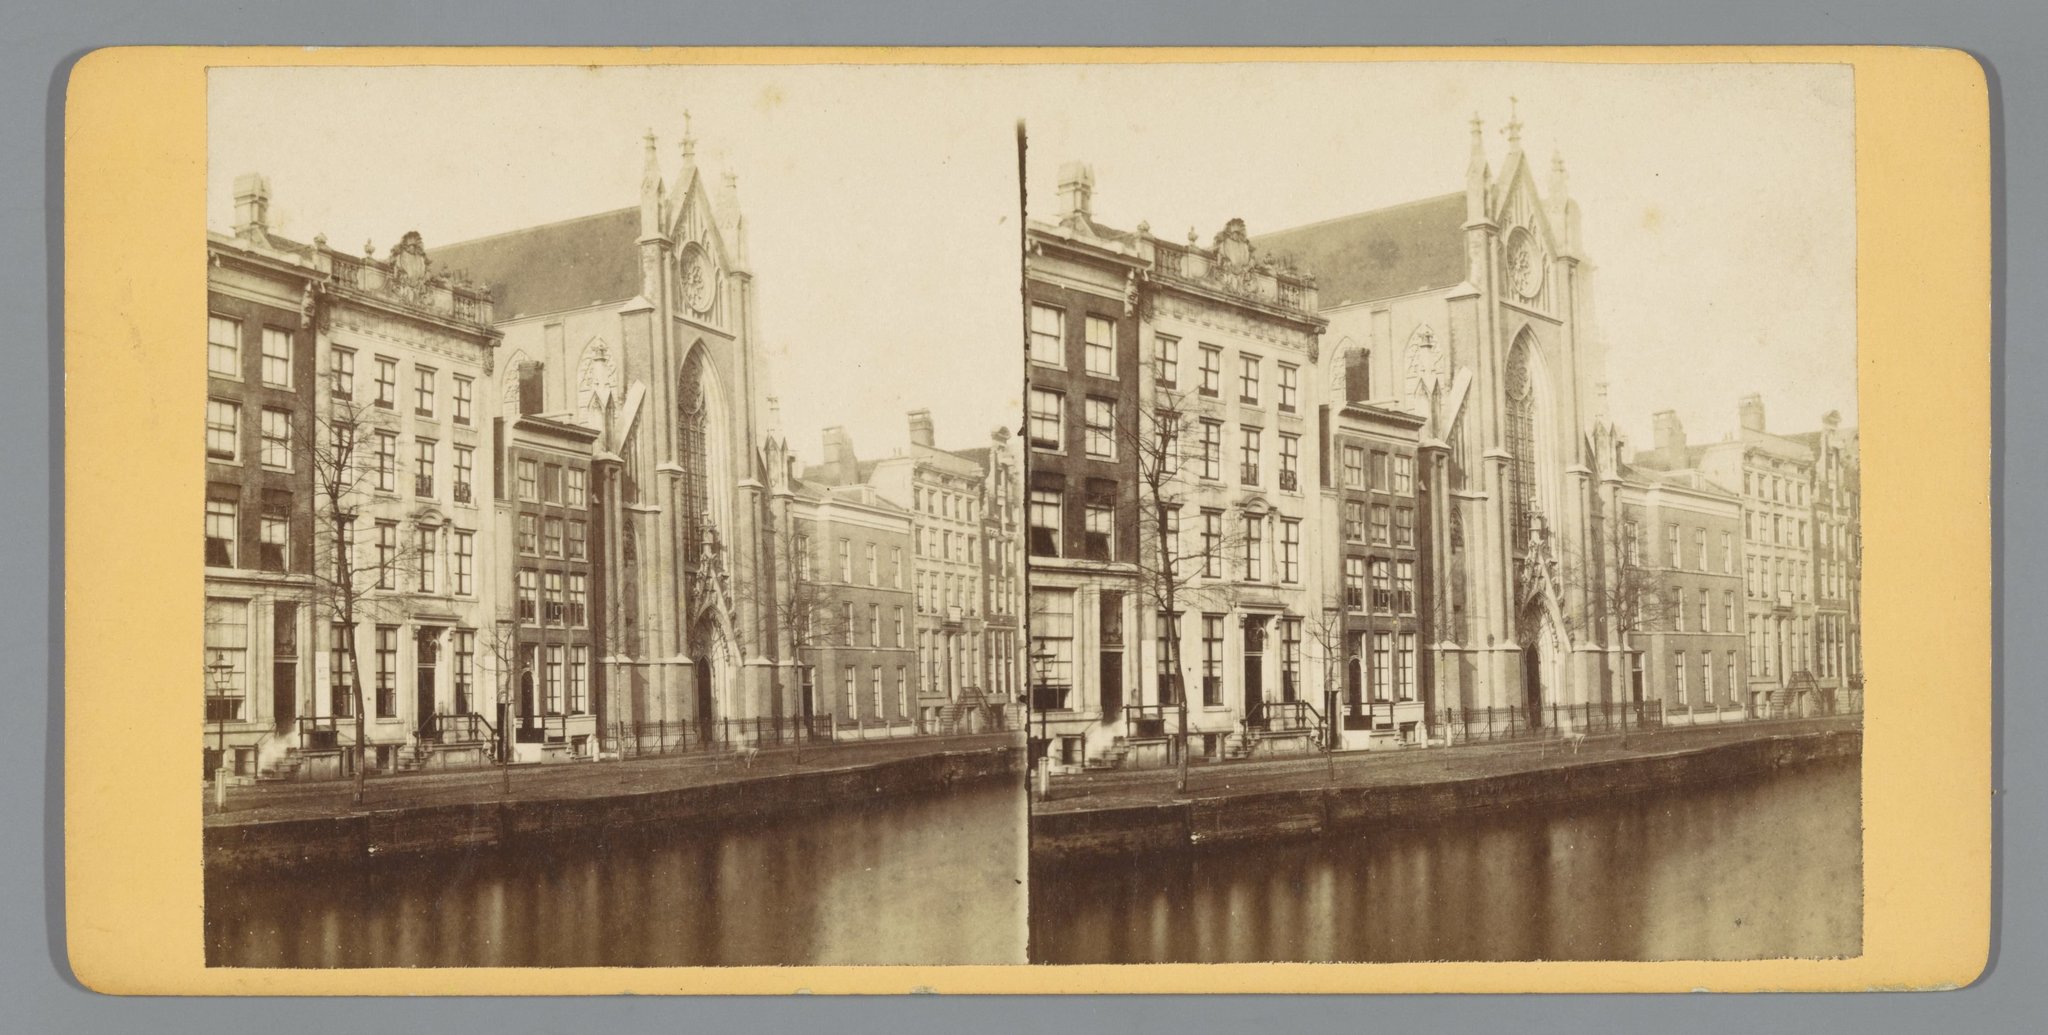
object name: stereograph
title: Onze-Lieve-Vrouwekerk aan de Keizersgracht, Amsterdam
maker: Anonymous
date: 1868-1890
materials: cardboard, paper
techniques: albumen print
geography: amsterdam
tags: church (exterior), canals, waters (in city)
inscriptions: inscription: ‘Keizersgracht/ O.L.V. Kerk/ Amsterdam’